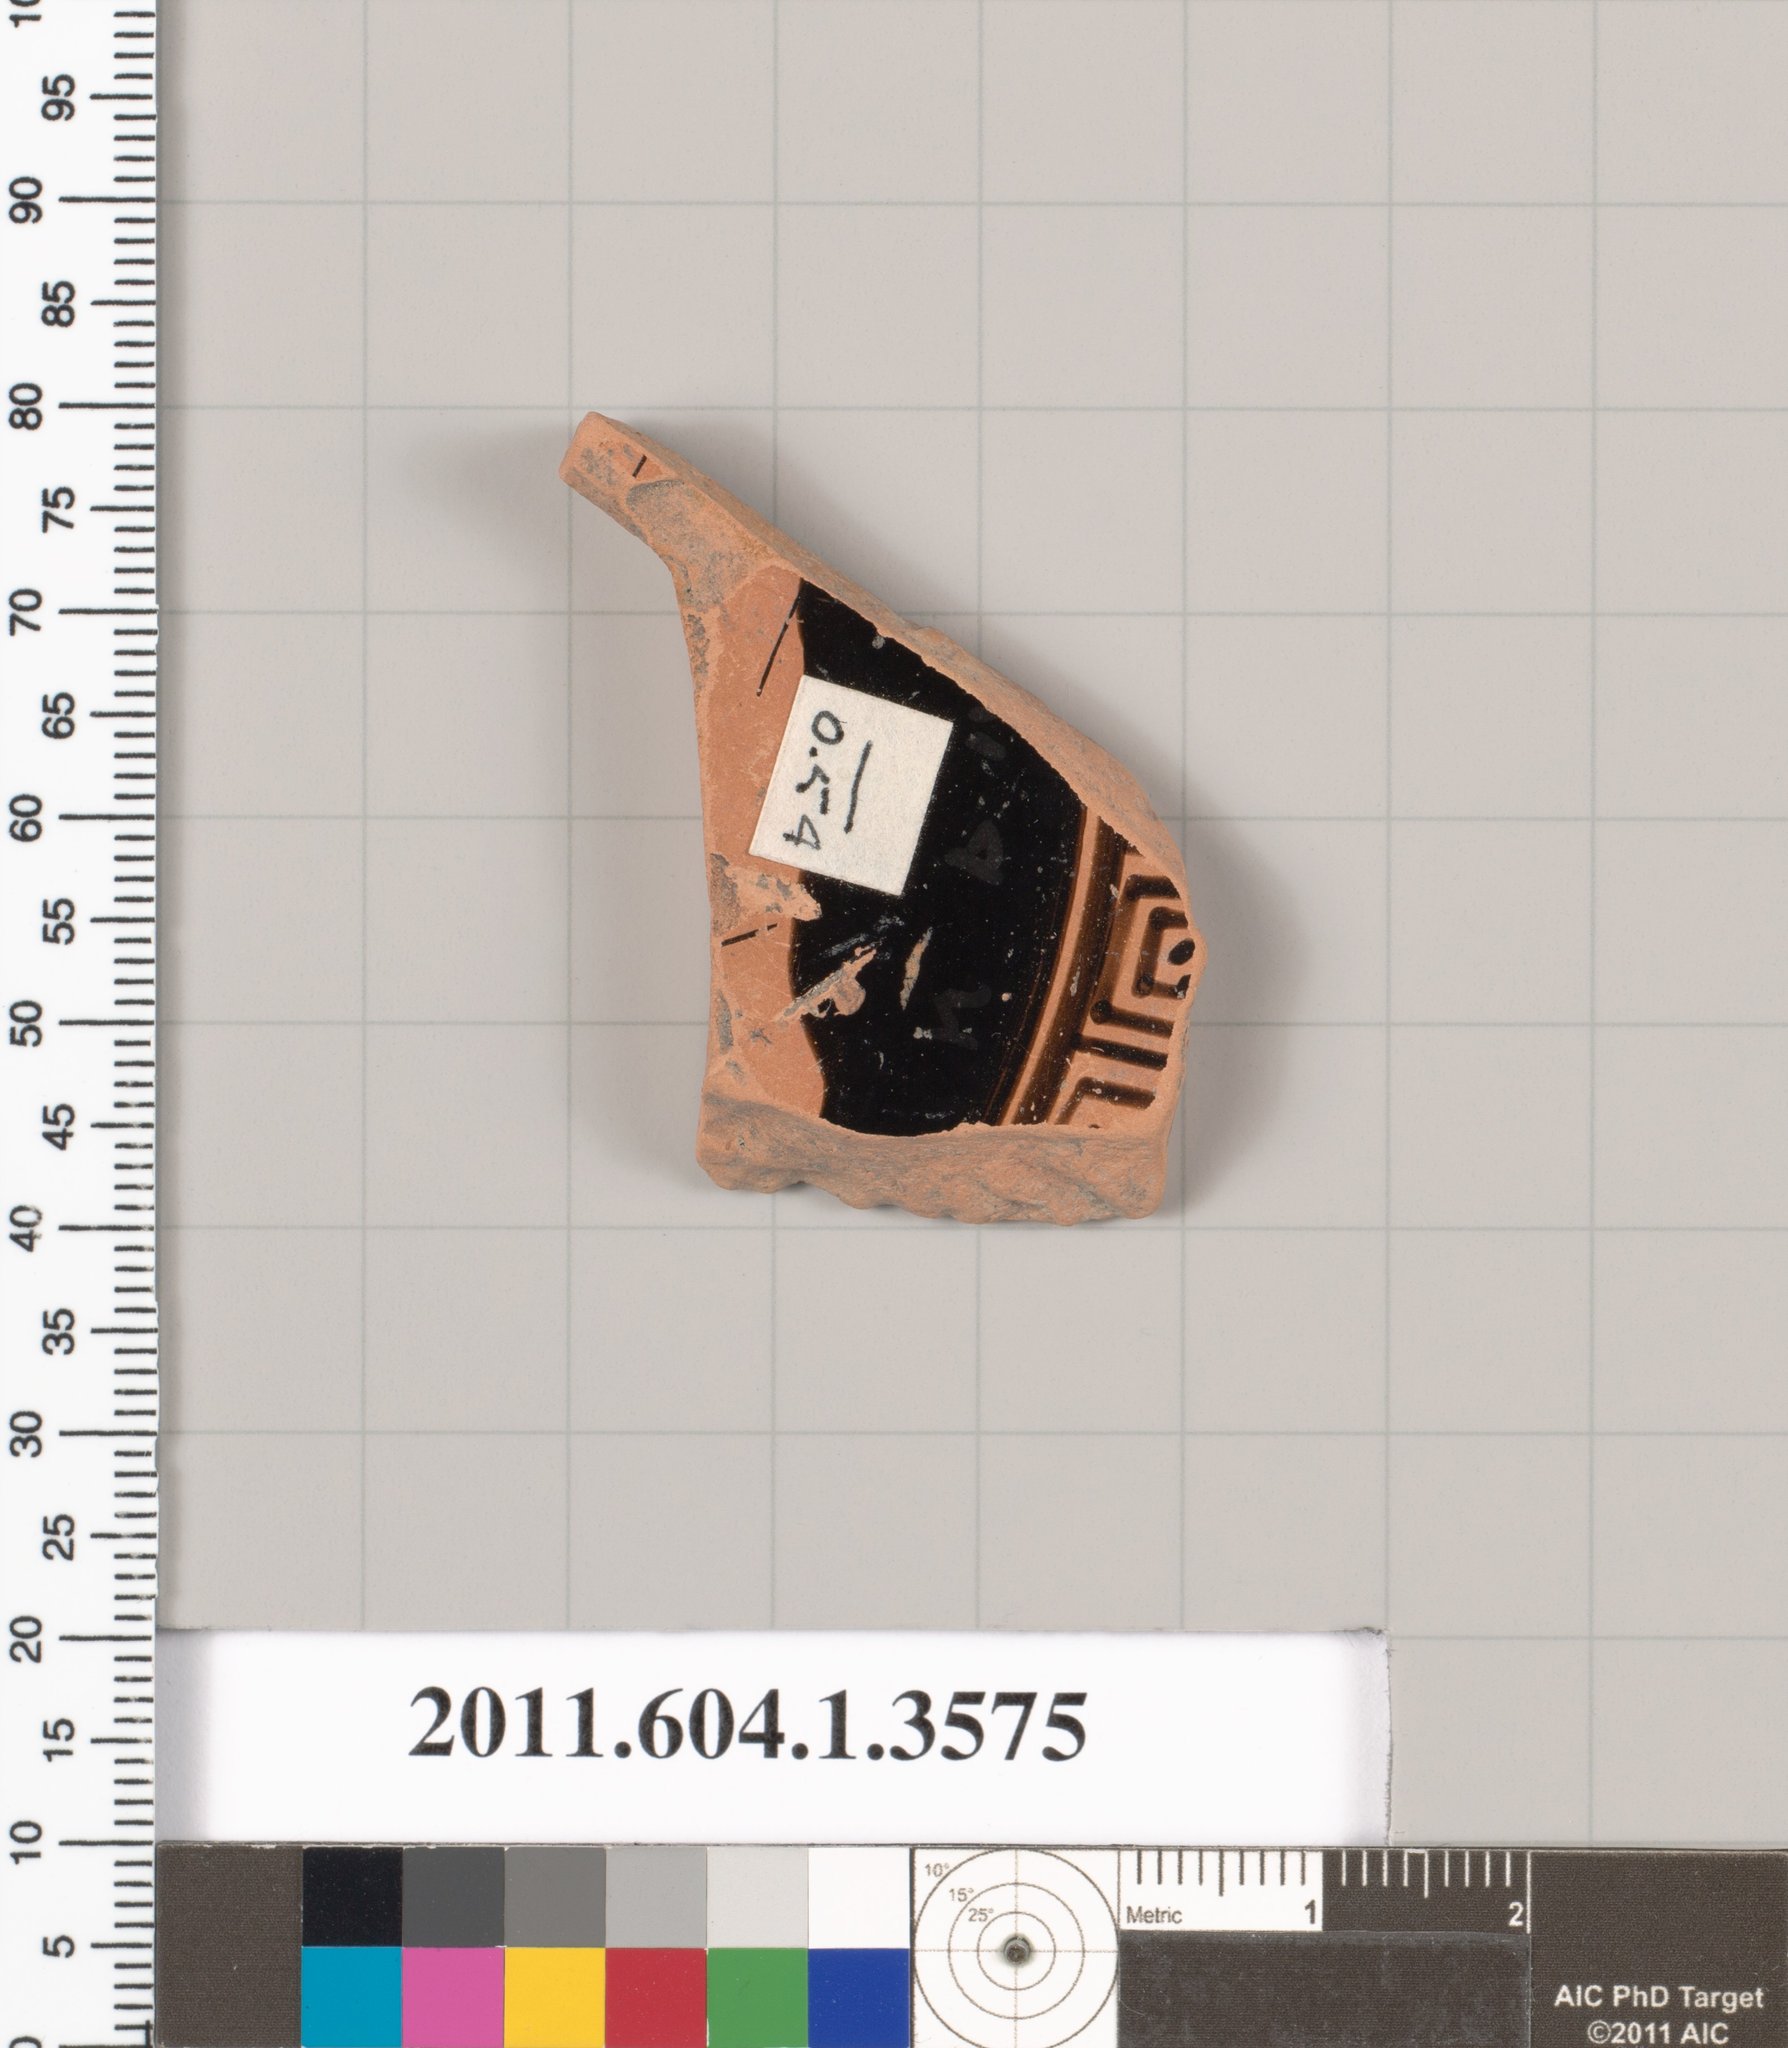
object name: kylix fragment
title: Terracotta fragment of a kylix (drinking cup)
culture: greek, attic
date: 475-451 BCE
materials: terracotta